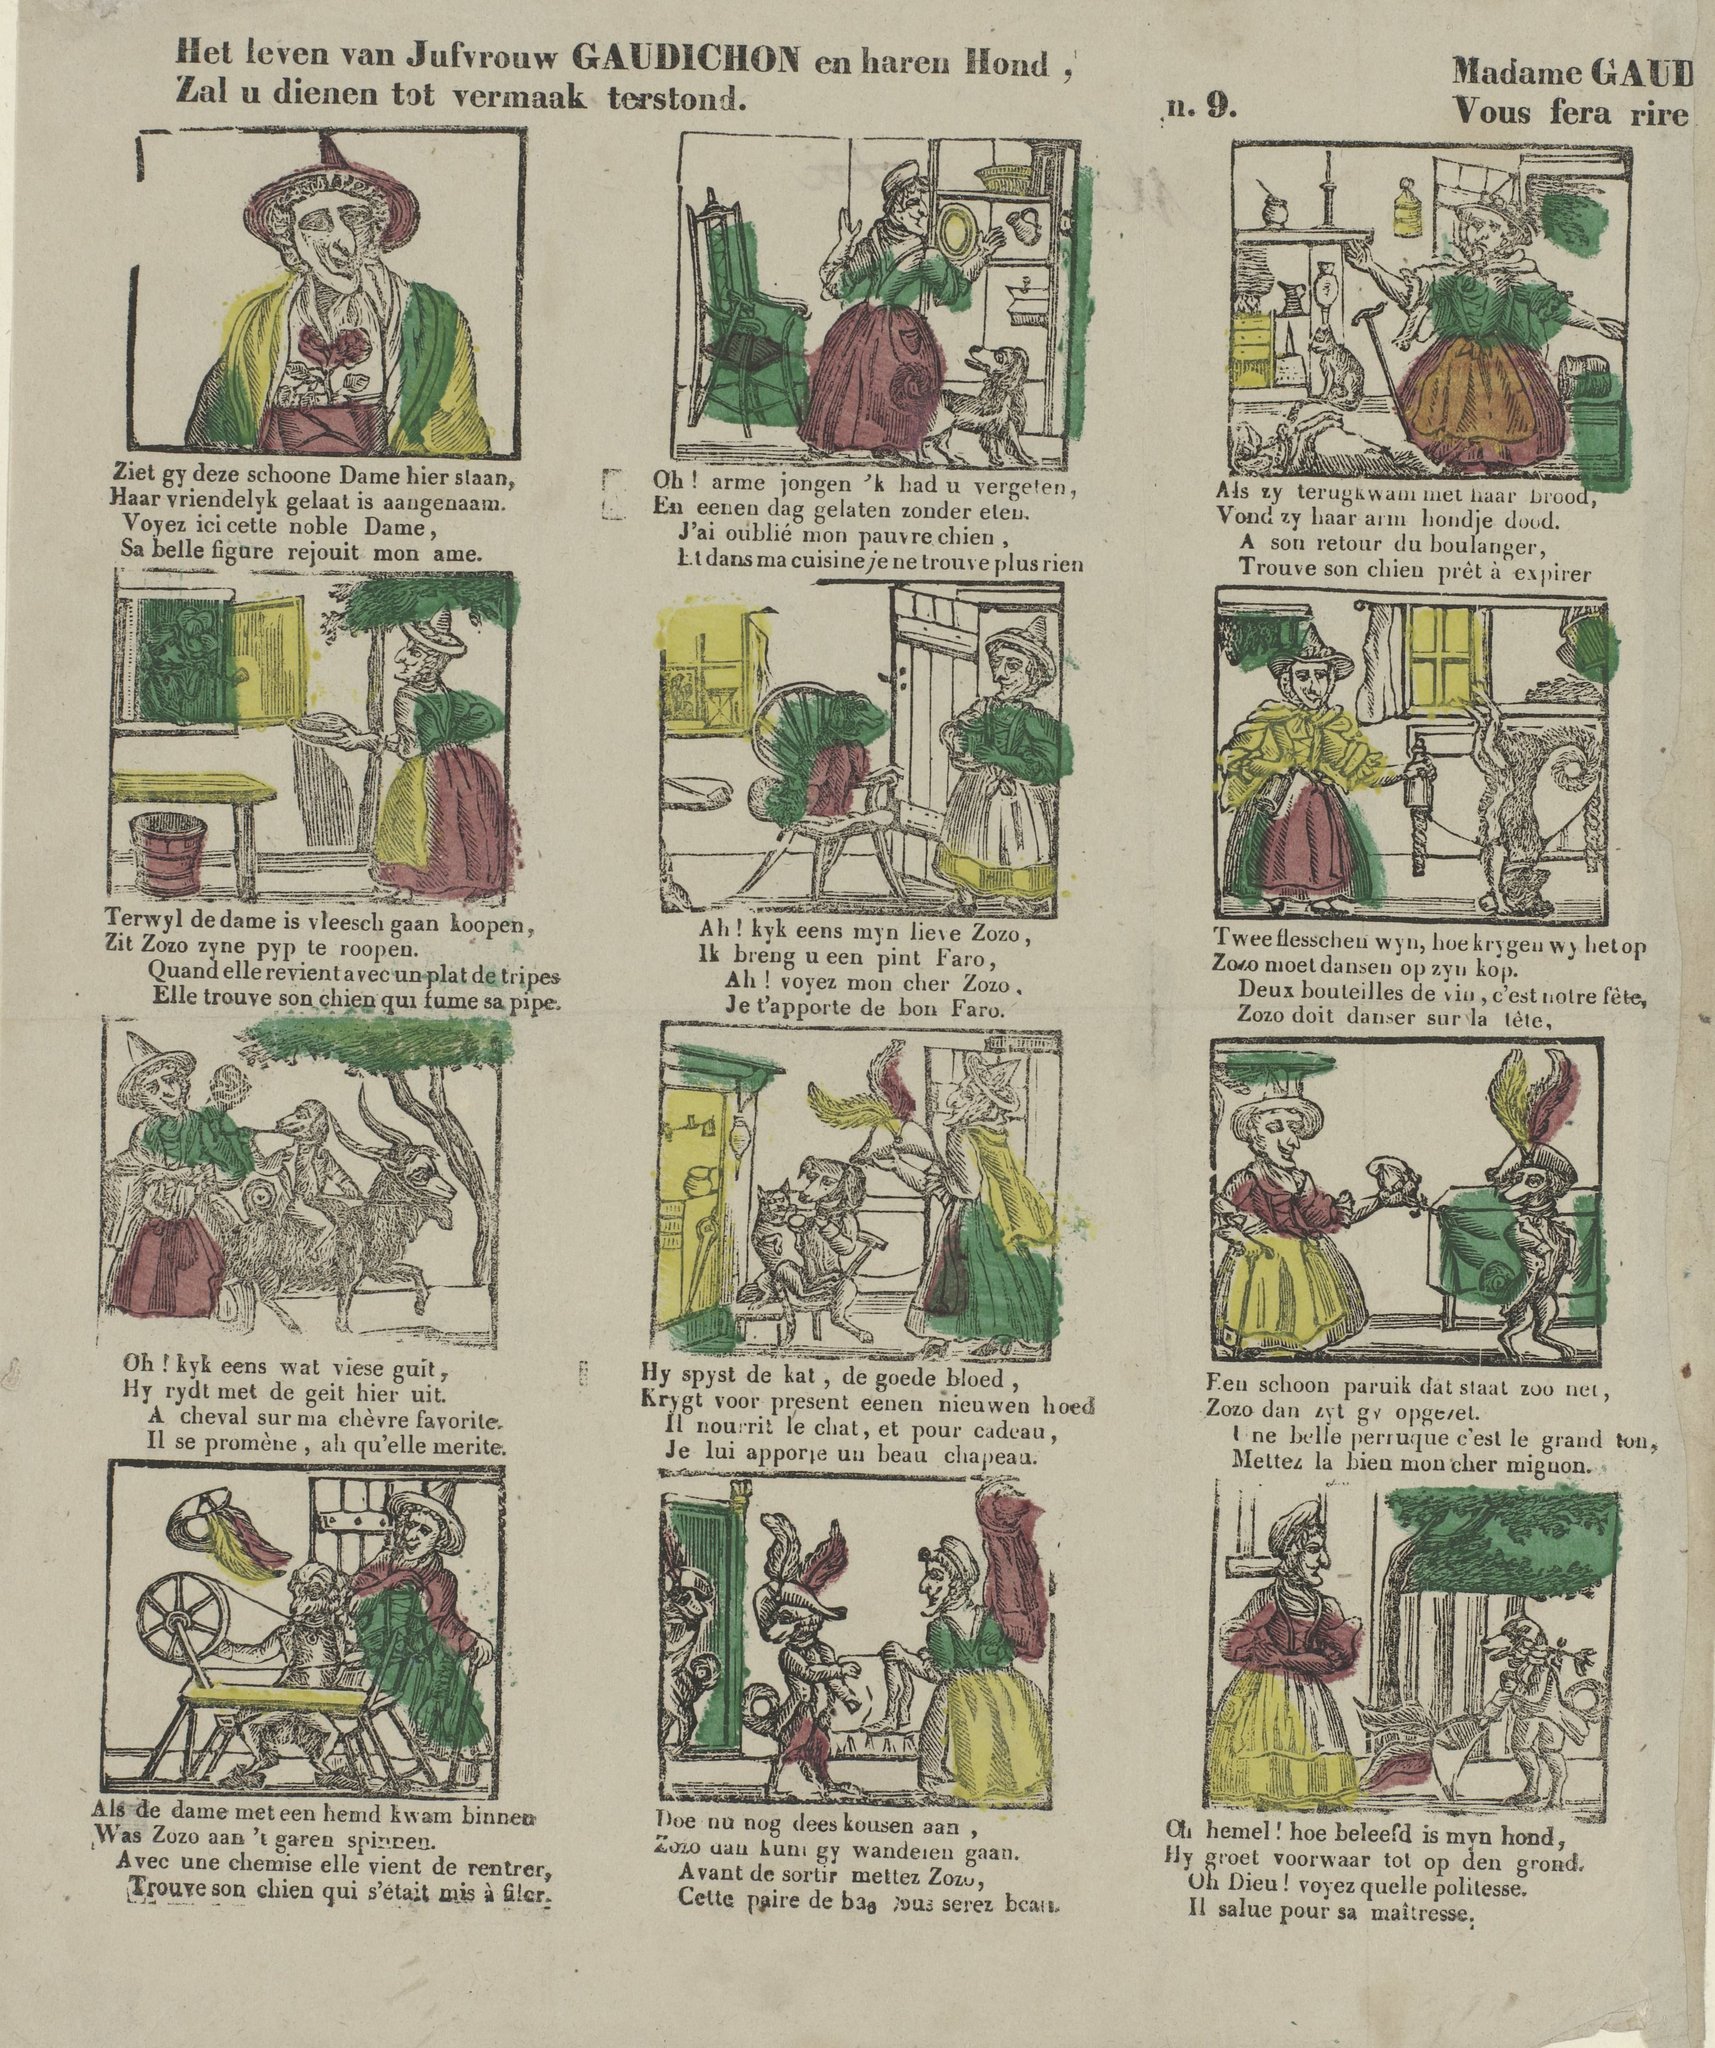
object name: popular print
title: het leven van juffrouw Gaudichon en haren hond, / Zal u dienen tot vermaak terstond (...)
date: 1842-1856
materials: paper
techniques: colour, letterpress printing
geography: turnhout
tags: 'mundus inversus', the reversed world, the topsy-turvy world, 'le monde bestourné', dog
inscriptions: collector's mark: Lugt 2760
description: Blad met 12 voorstellingen uit het leven van juffrouw Gaudichon en haar hond. De hond kan allerlei kunstjes, waaronder op zijn kop staan, de pijp roken, op de fluit spelen, spinnen, gekleed gaan met schoenen, broek, jas en steek. Onder elke voorstelling een tweeregelig vers in het Nederlands en het Frans. Genummerd midden boven: n. 9.